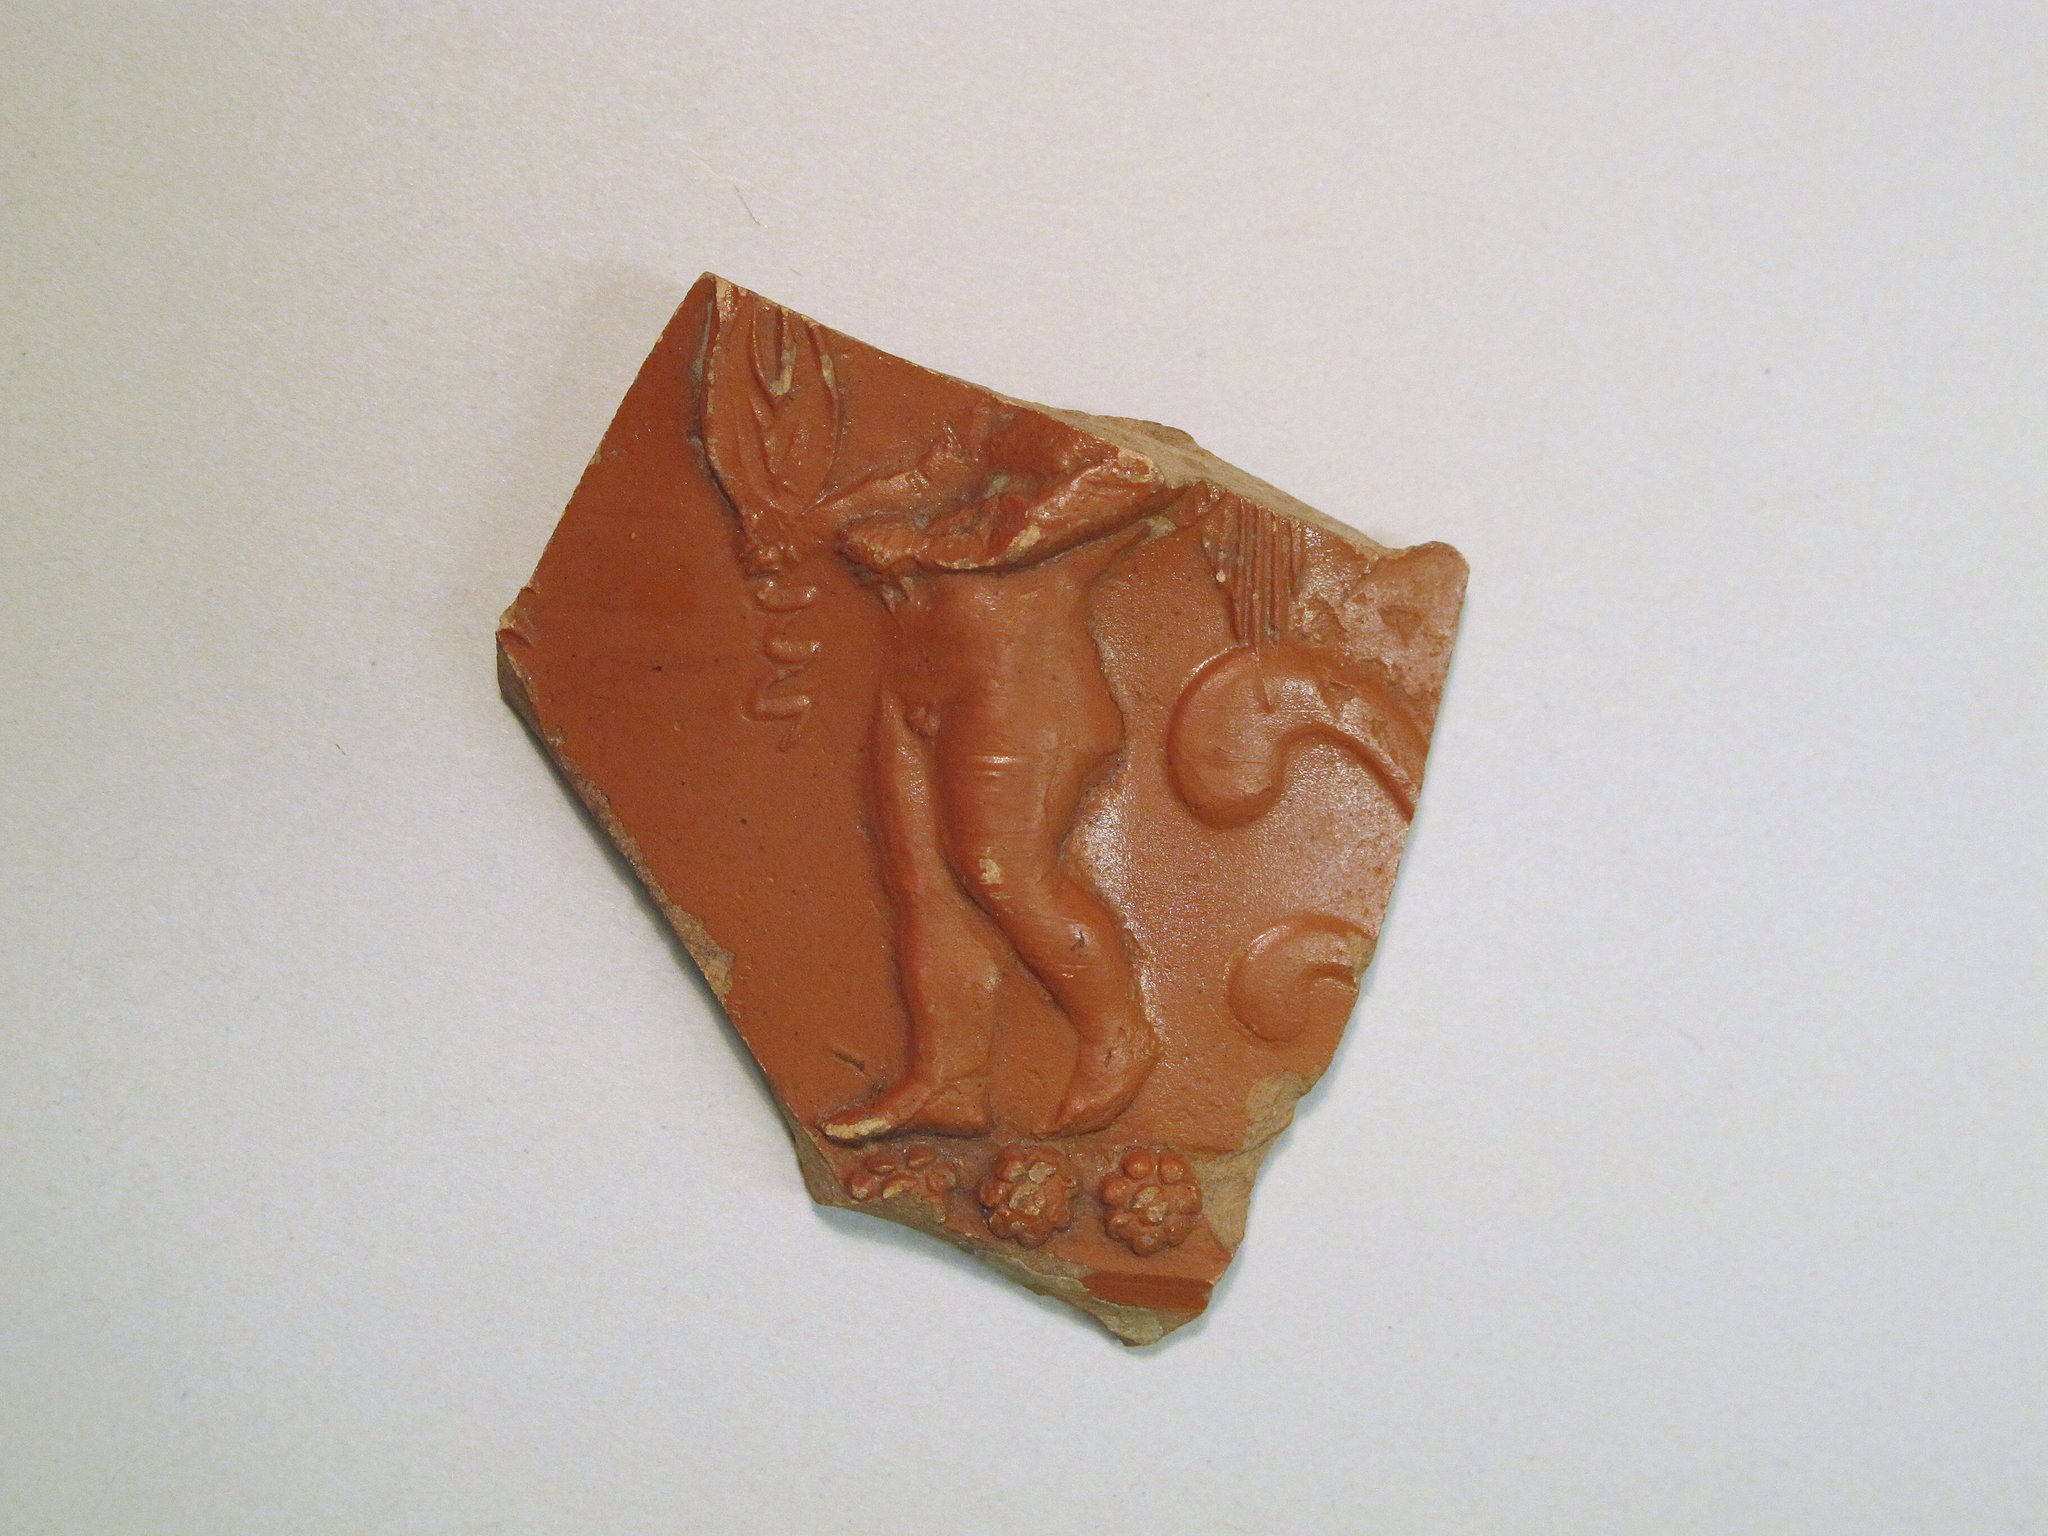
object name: vase fragment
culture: roman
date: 670 BCE-330 CE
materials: terracotta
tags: eros